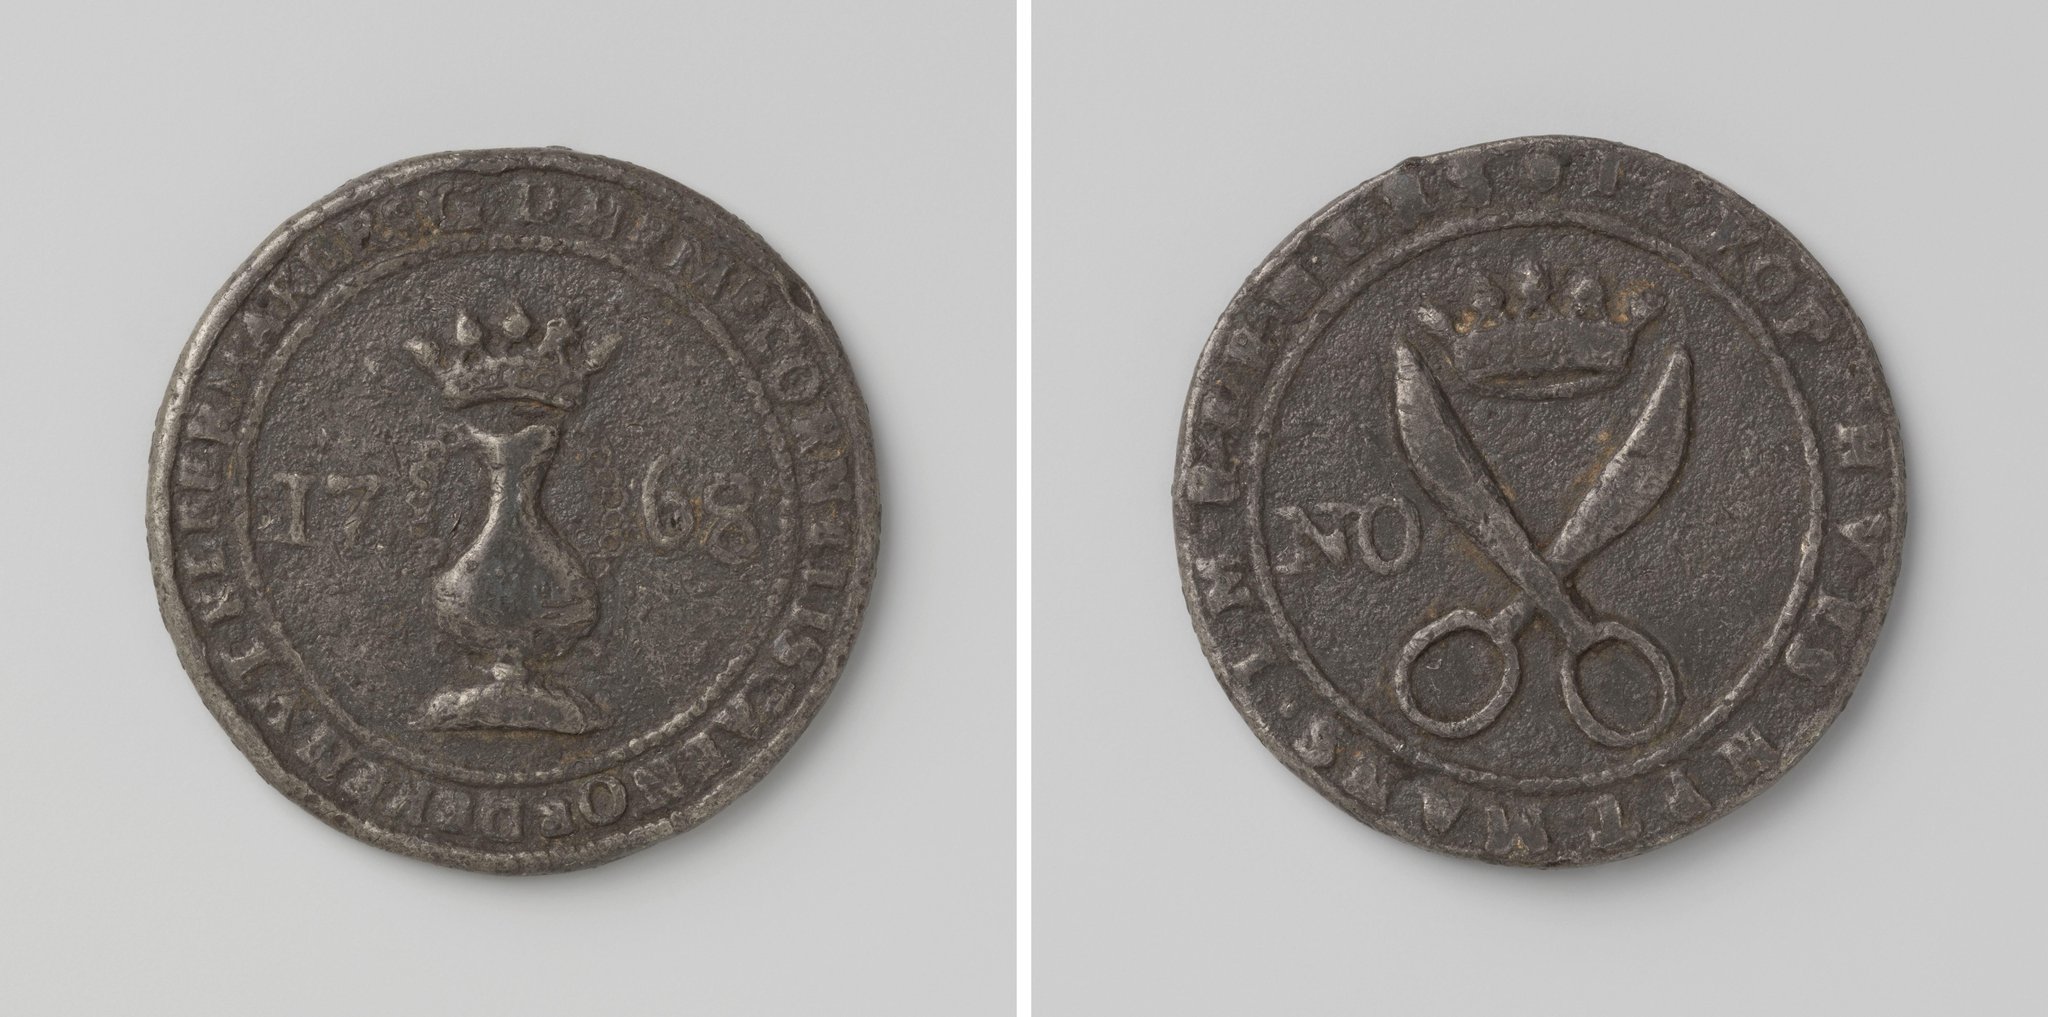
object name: medal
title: Kleermakersgilde van Vlissingen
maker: Anonymous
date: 1768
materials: lead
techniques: casting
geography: flushing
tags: flushing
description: Loden penning. Voorzijde: gekroonde fles tussen jaartal binnen omschrift. Keerzijde: gekroonde schaar naast opschrift No. binnen omschrift